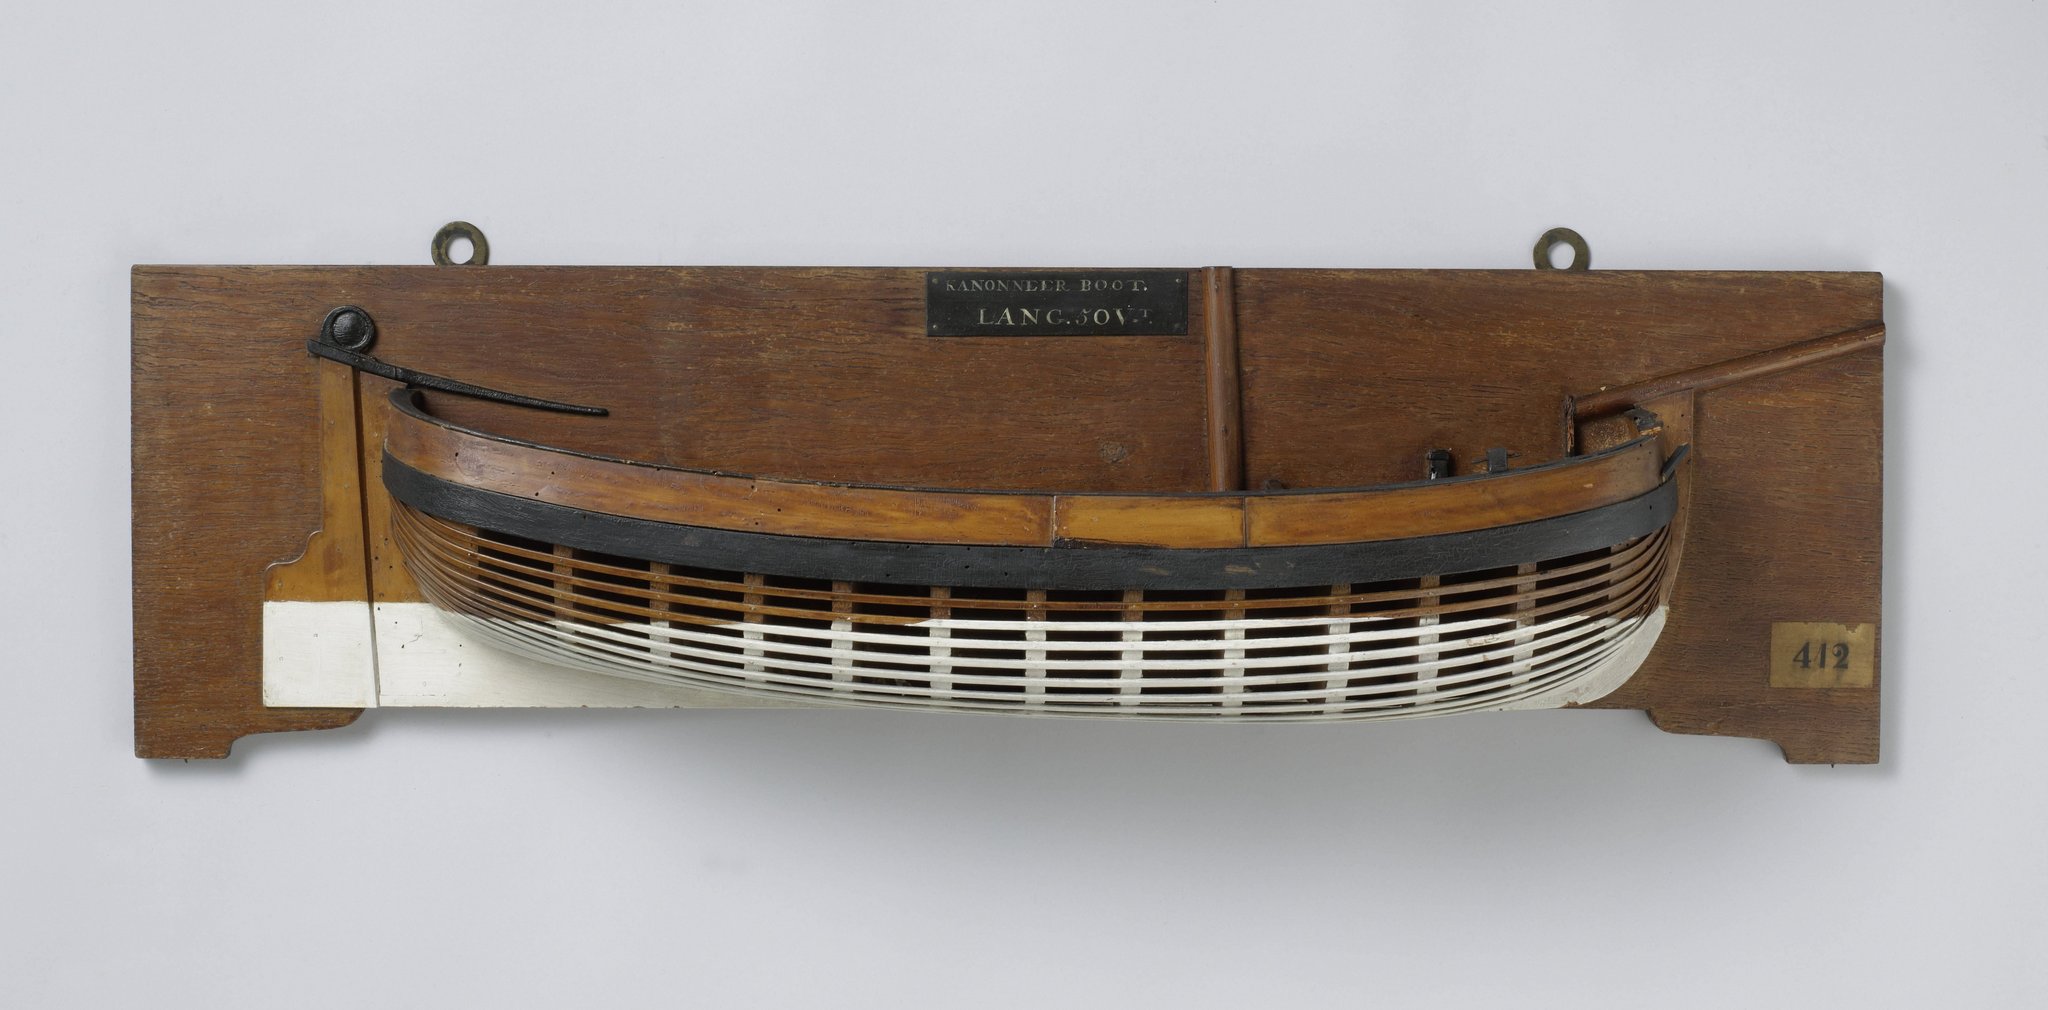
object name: half model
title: Half Model of a Gunboat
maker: Anonymous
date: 1780-1820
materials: wood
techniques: polychromy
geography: netherlands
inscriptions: label, bottom right: ‘412’ former inventory label, inscription, top centre, on a rectangular black label: ‘KANONNEER BOOT. / LANG. 50 Vt.’